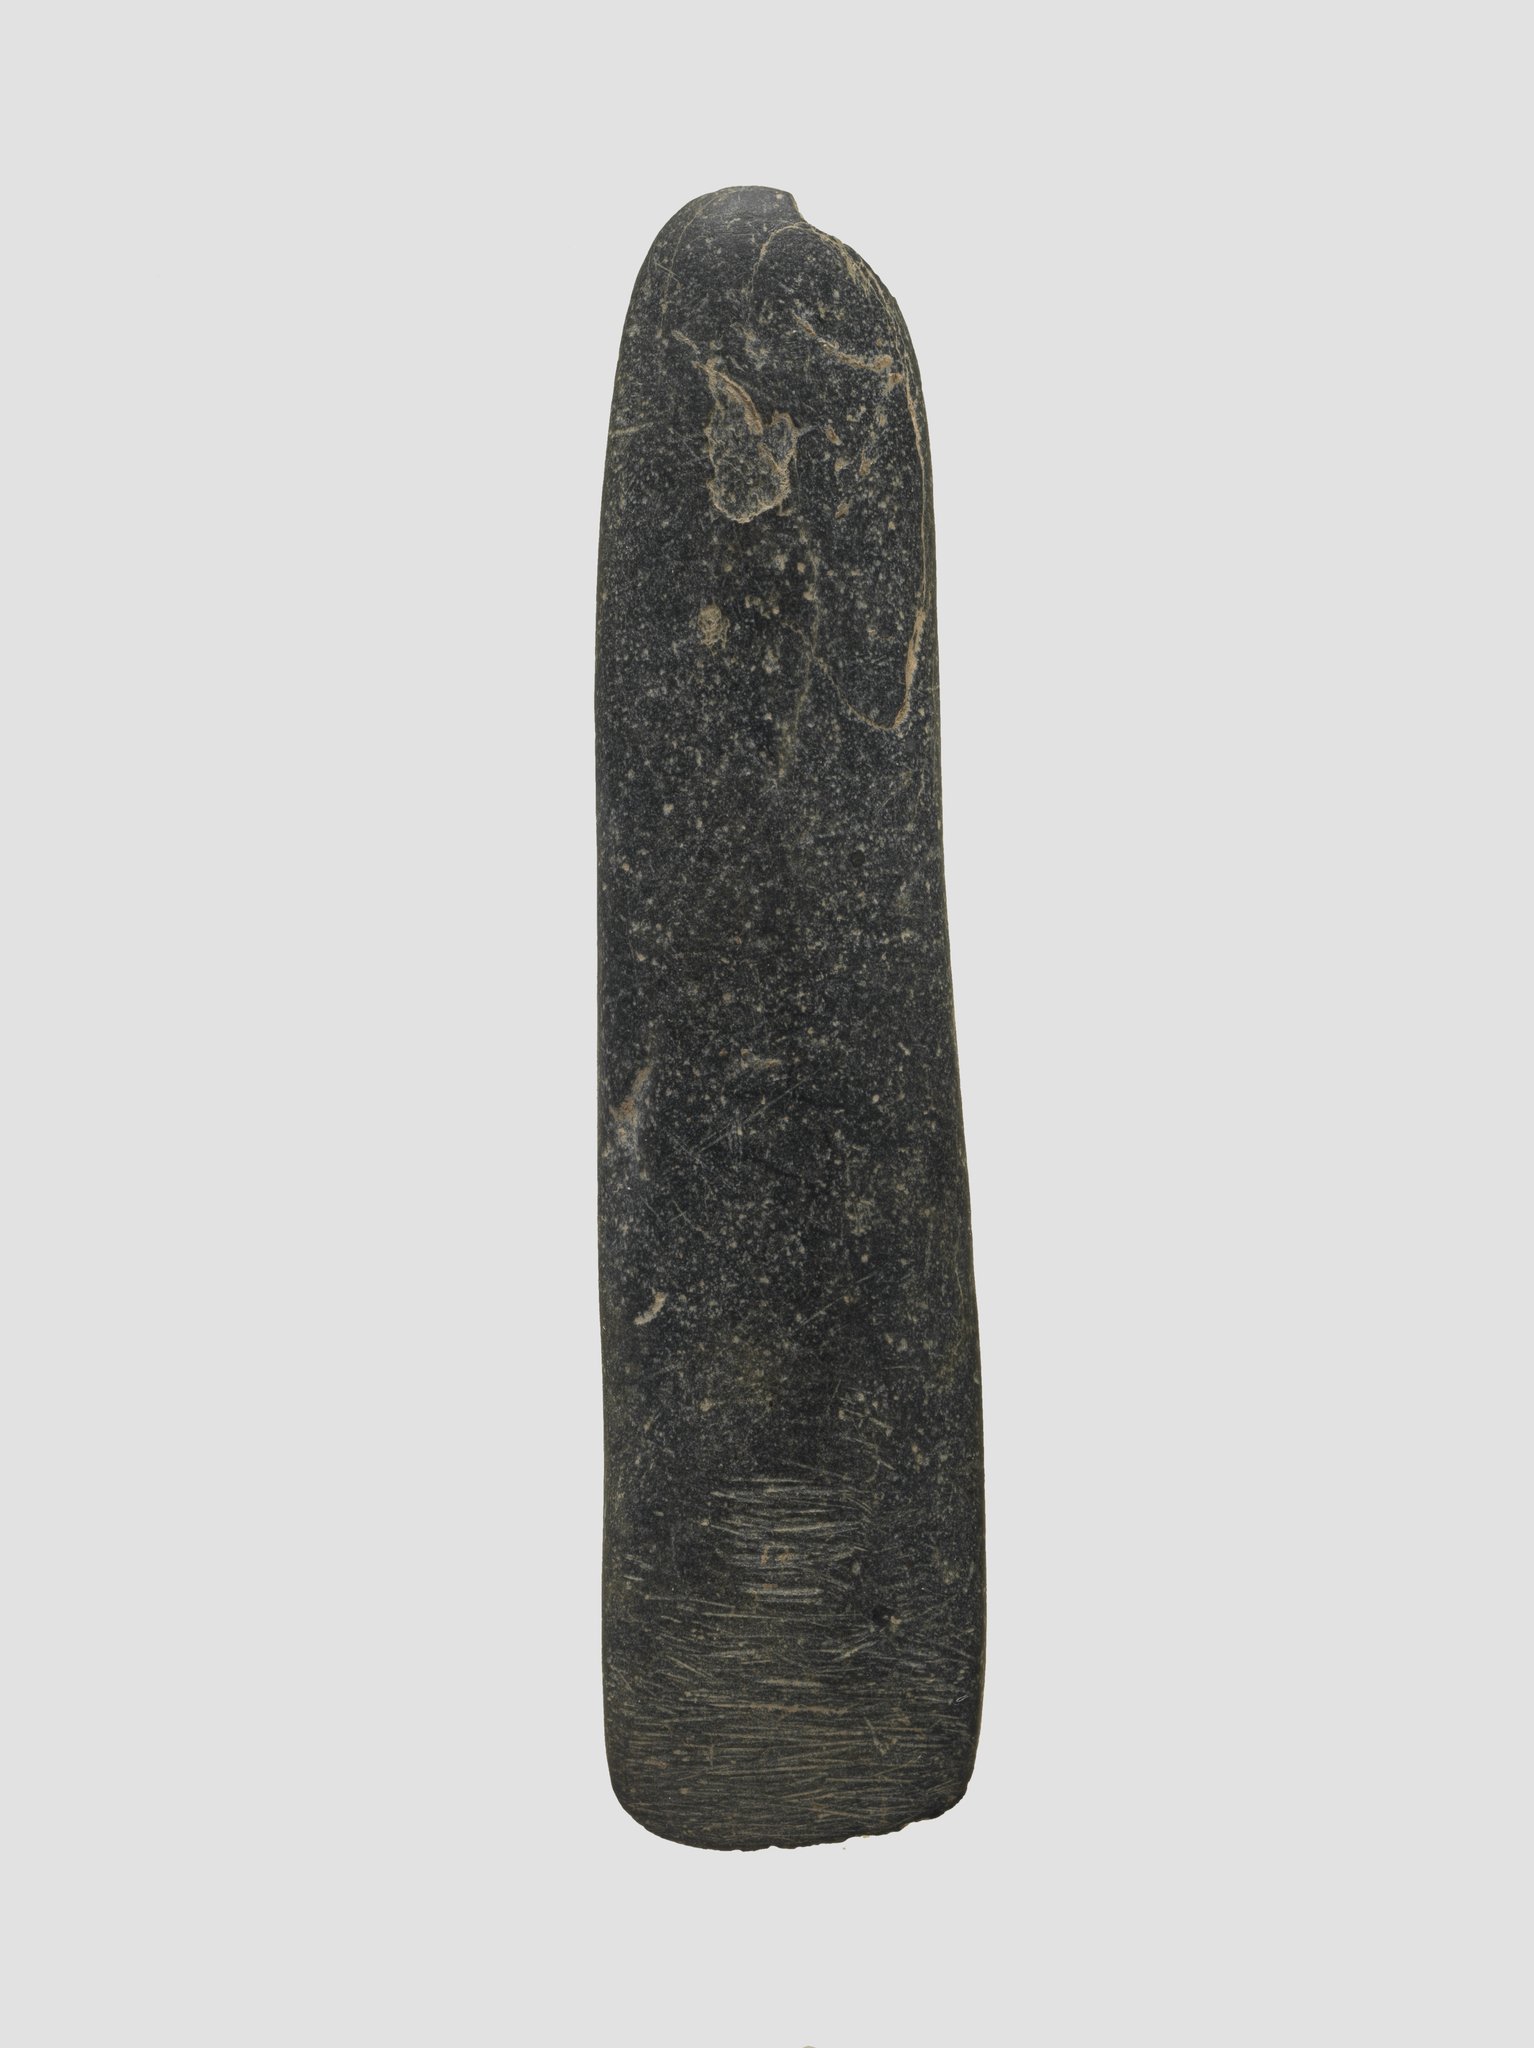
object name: scraper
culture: iranian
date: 5000-2001 BCE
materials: stone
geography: iran